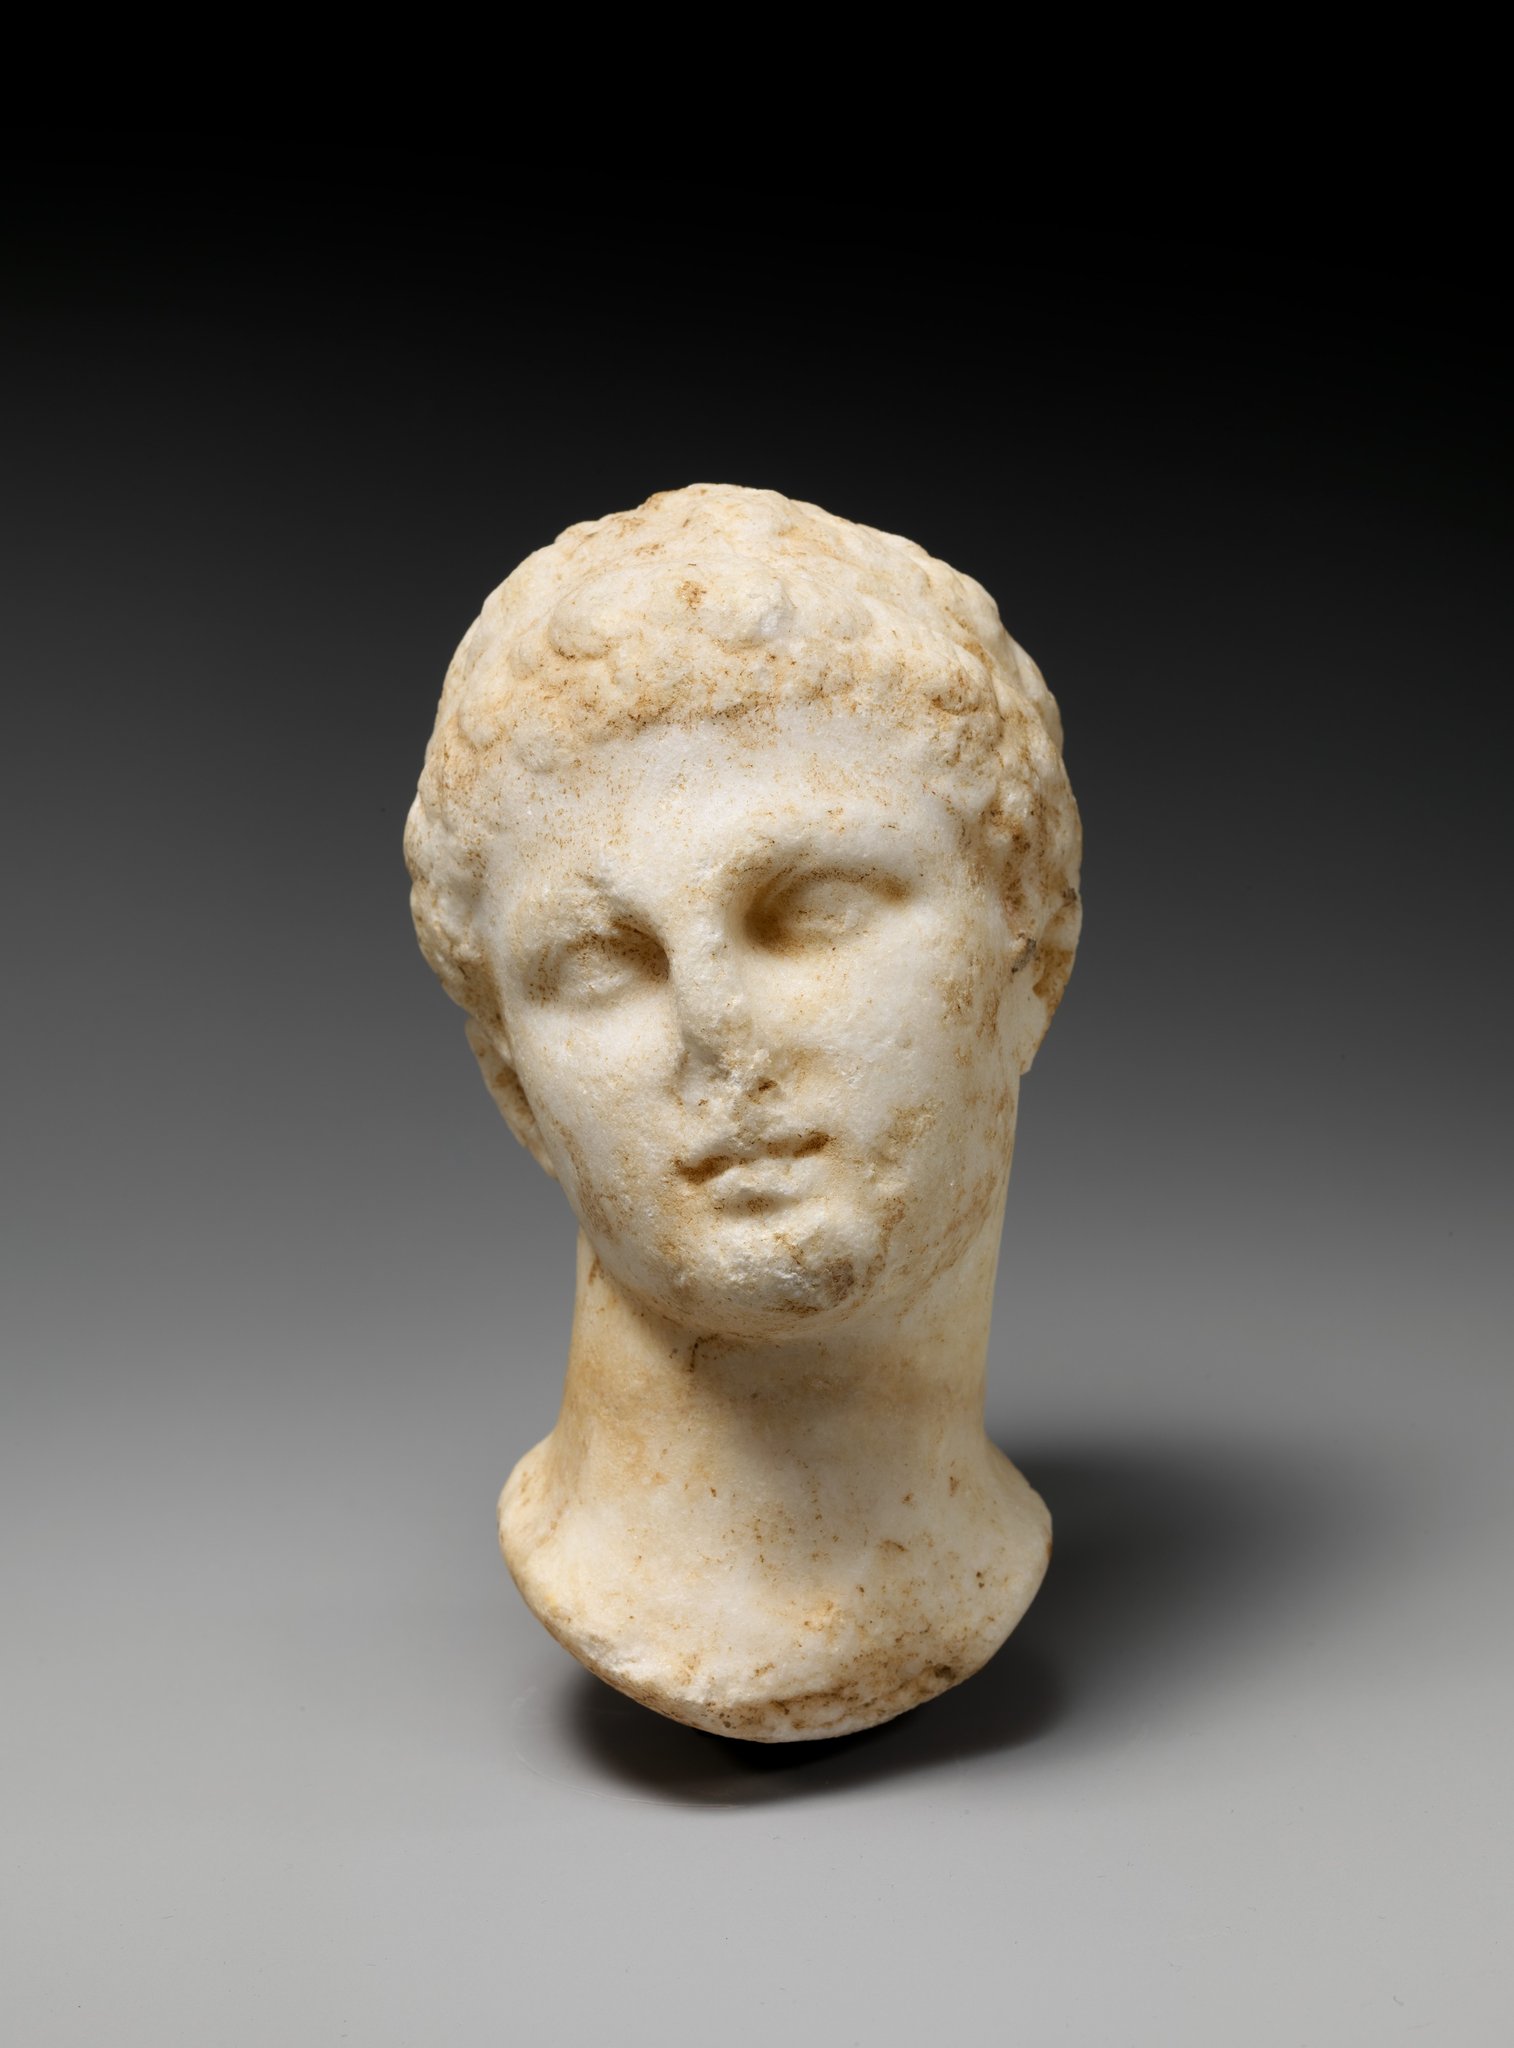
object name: head of a youth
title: Marble head of a youth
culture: greek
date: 300-201 BCE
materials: marble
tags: heads,men